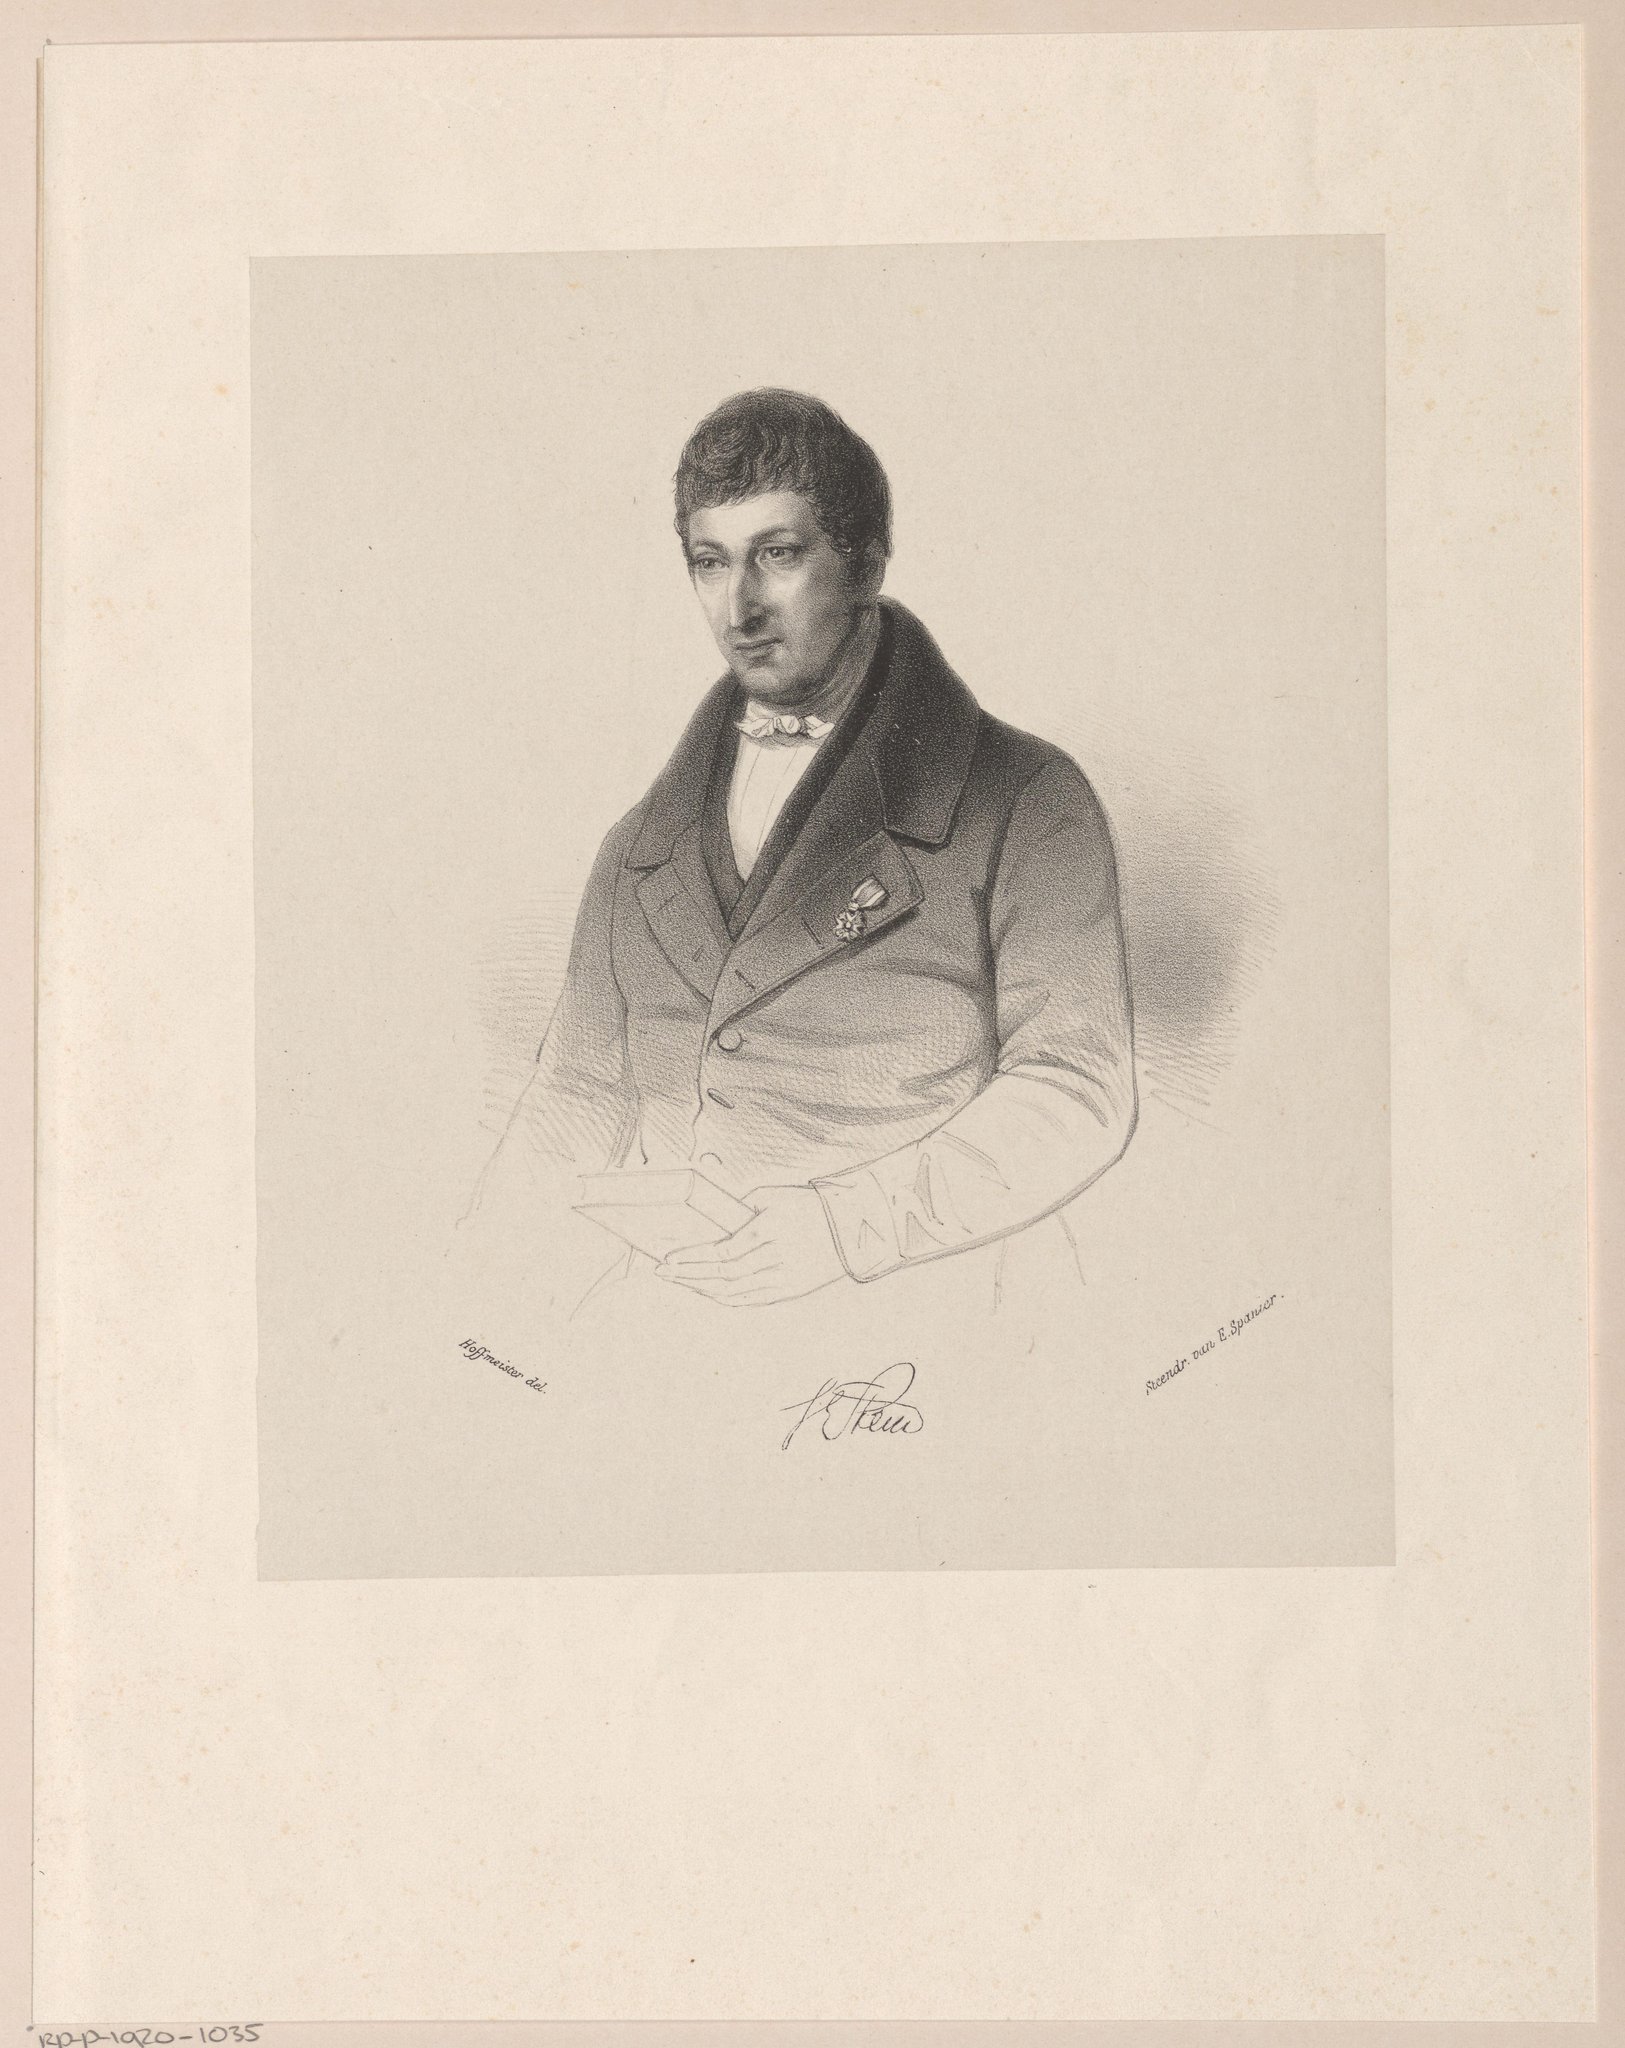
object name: print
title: Portret van Samuel Elias Stein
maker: johan hendrik hoffmeister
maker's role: print maker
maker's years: 1823-1904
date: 1851-1883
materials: paper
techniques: lithograph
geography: the hague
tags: the hague, historical persons, physician, doctor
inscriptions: collector's mark: Lugt 2228